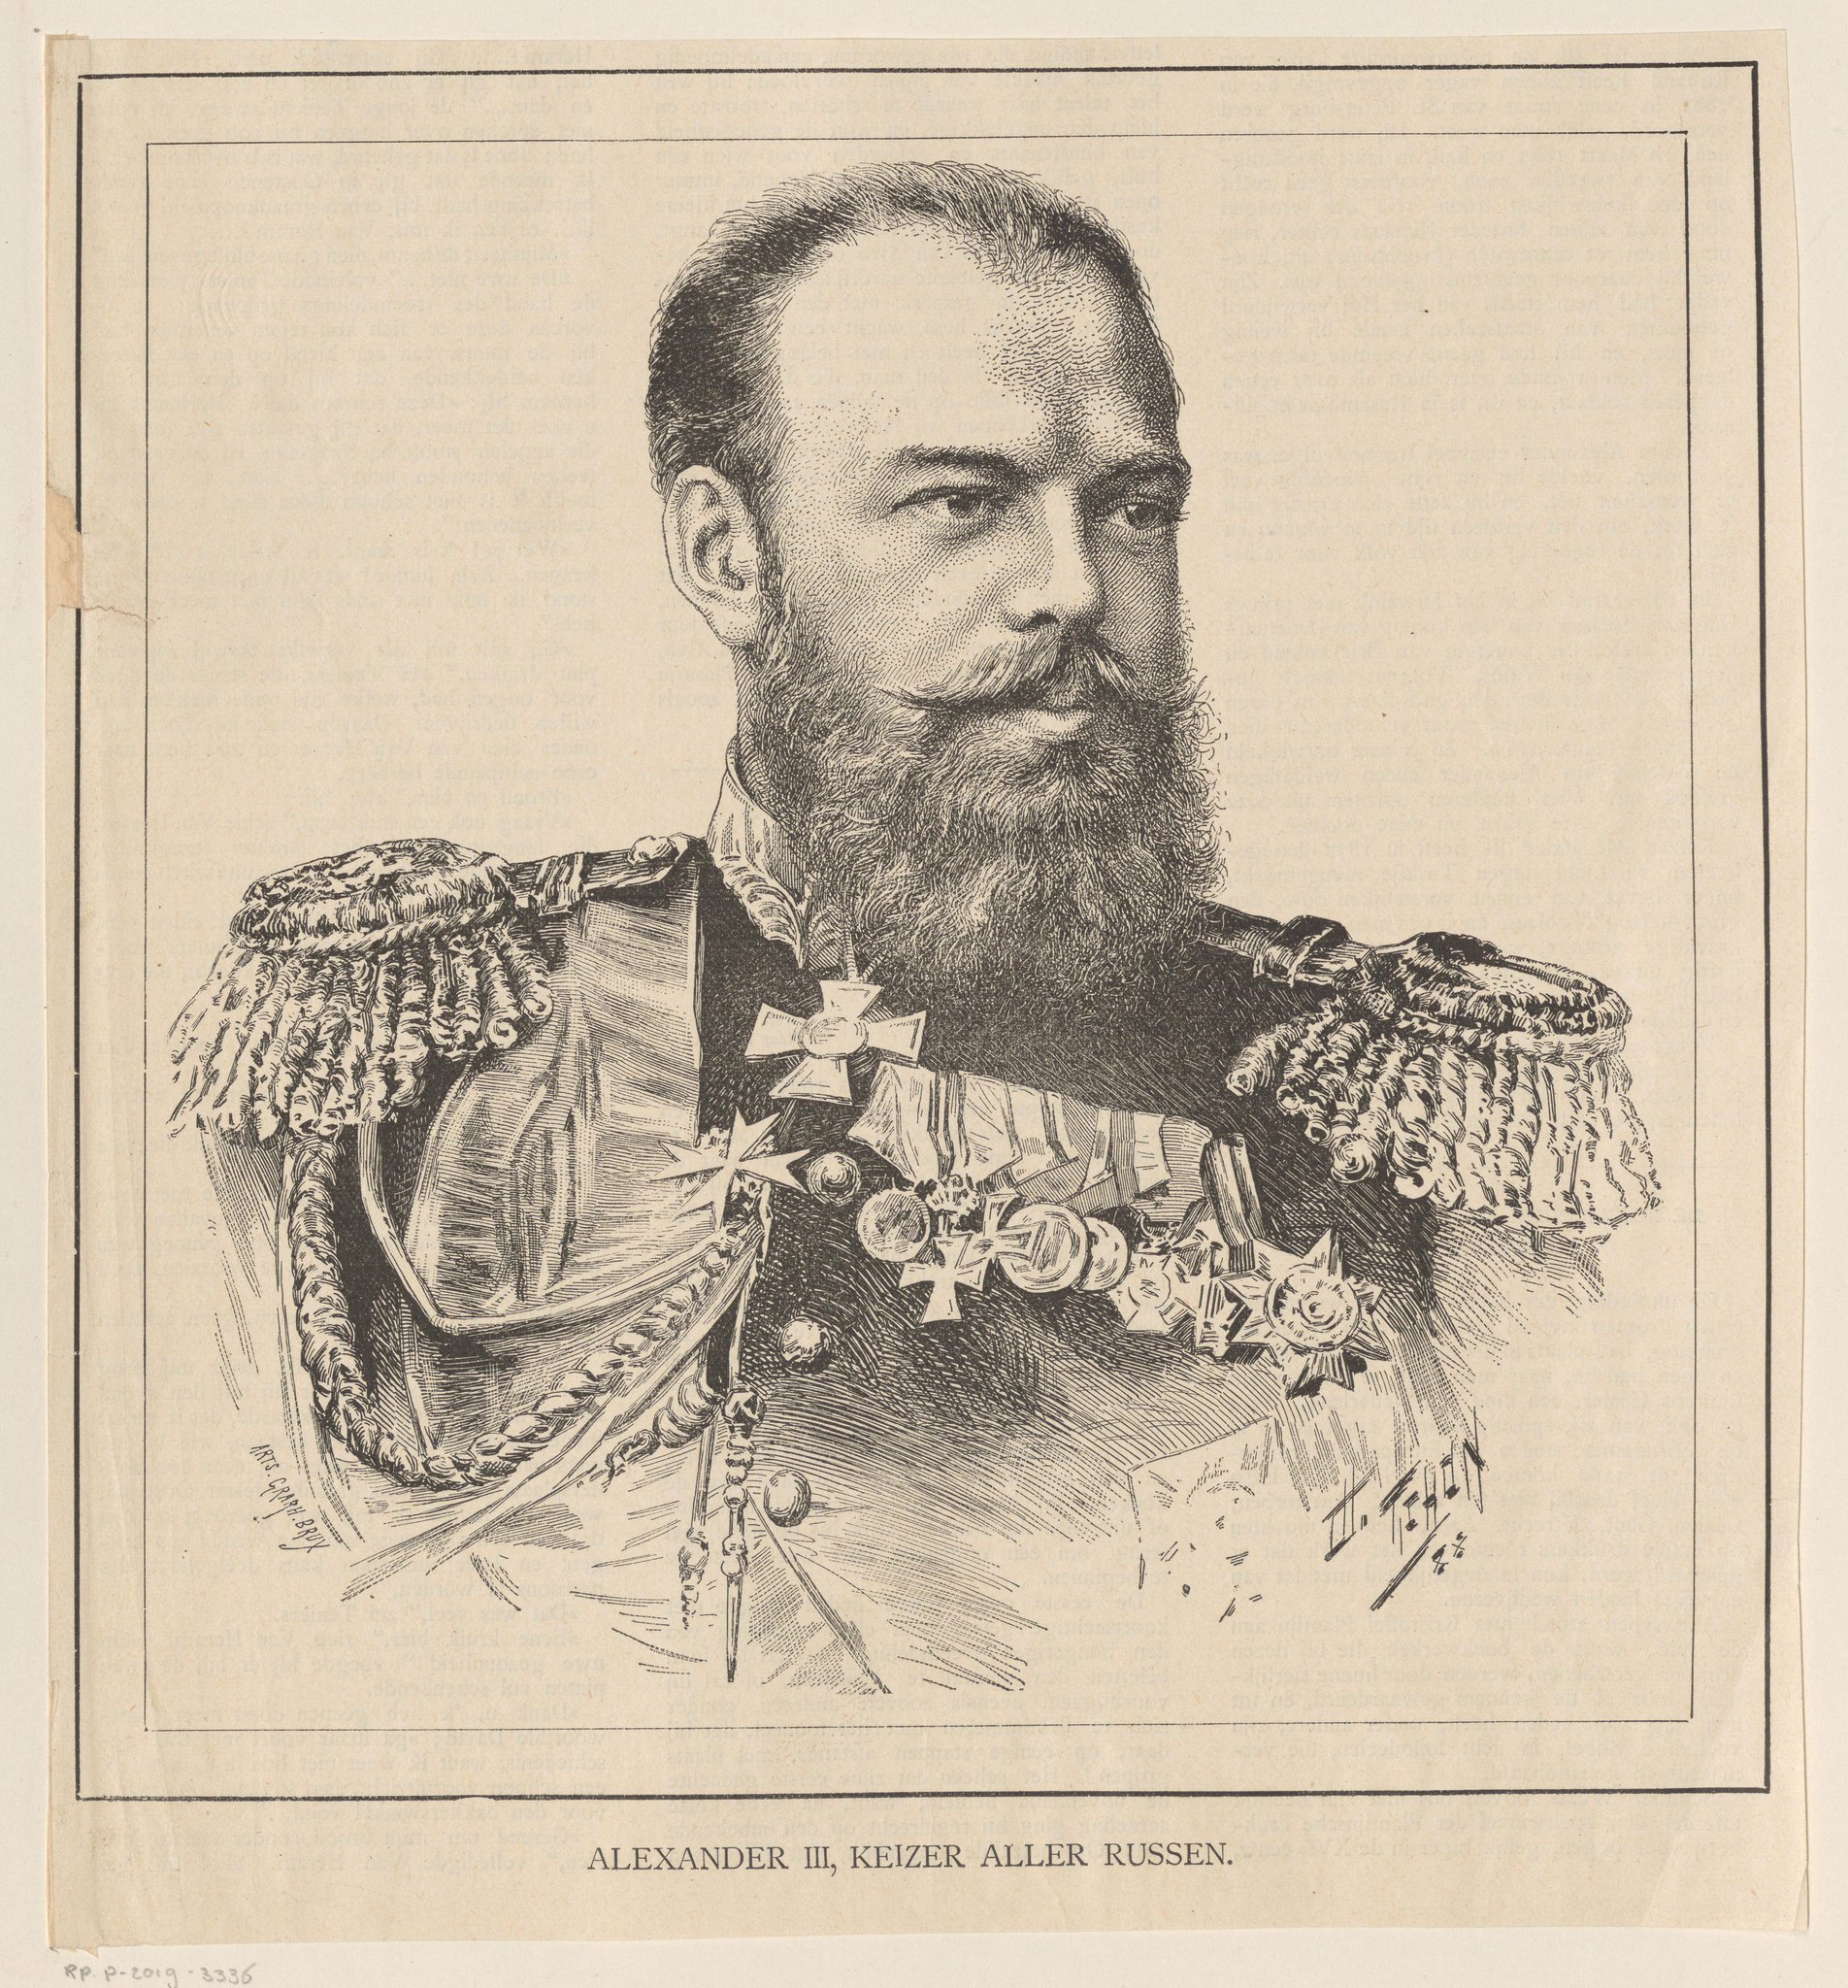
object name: print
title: Portret van Alexander III, tsaar van Rusland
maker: Anonymous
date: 1881-1885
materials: paper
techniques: letterpress printing, lithograph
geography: brussels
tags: historical persons, emperor